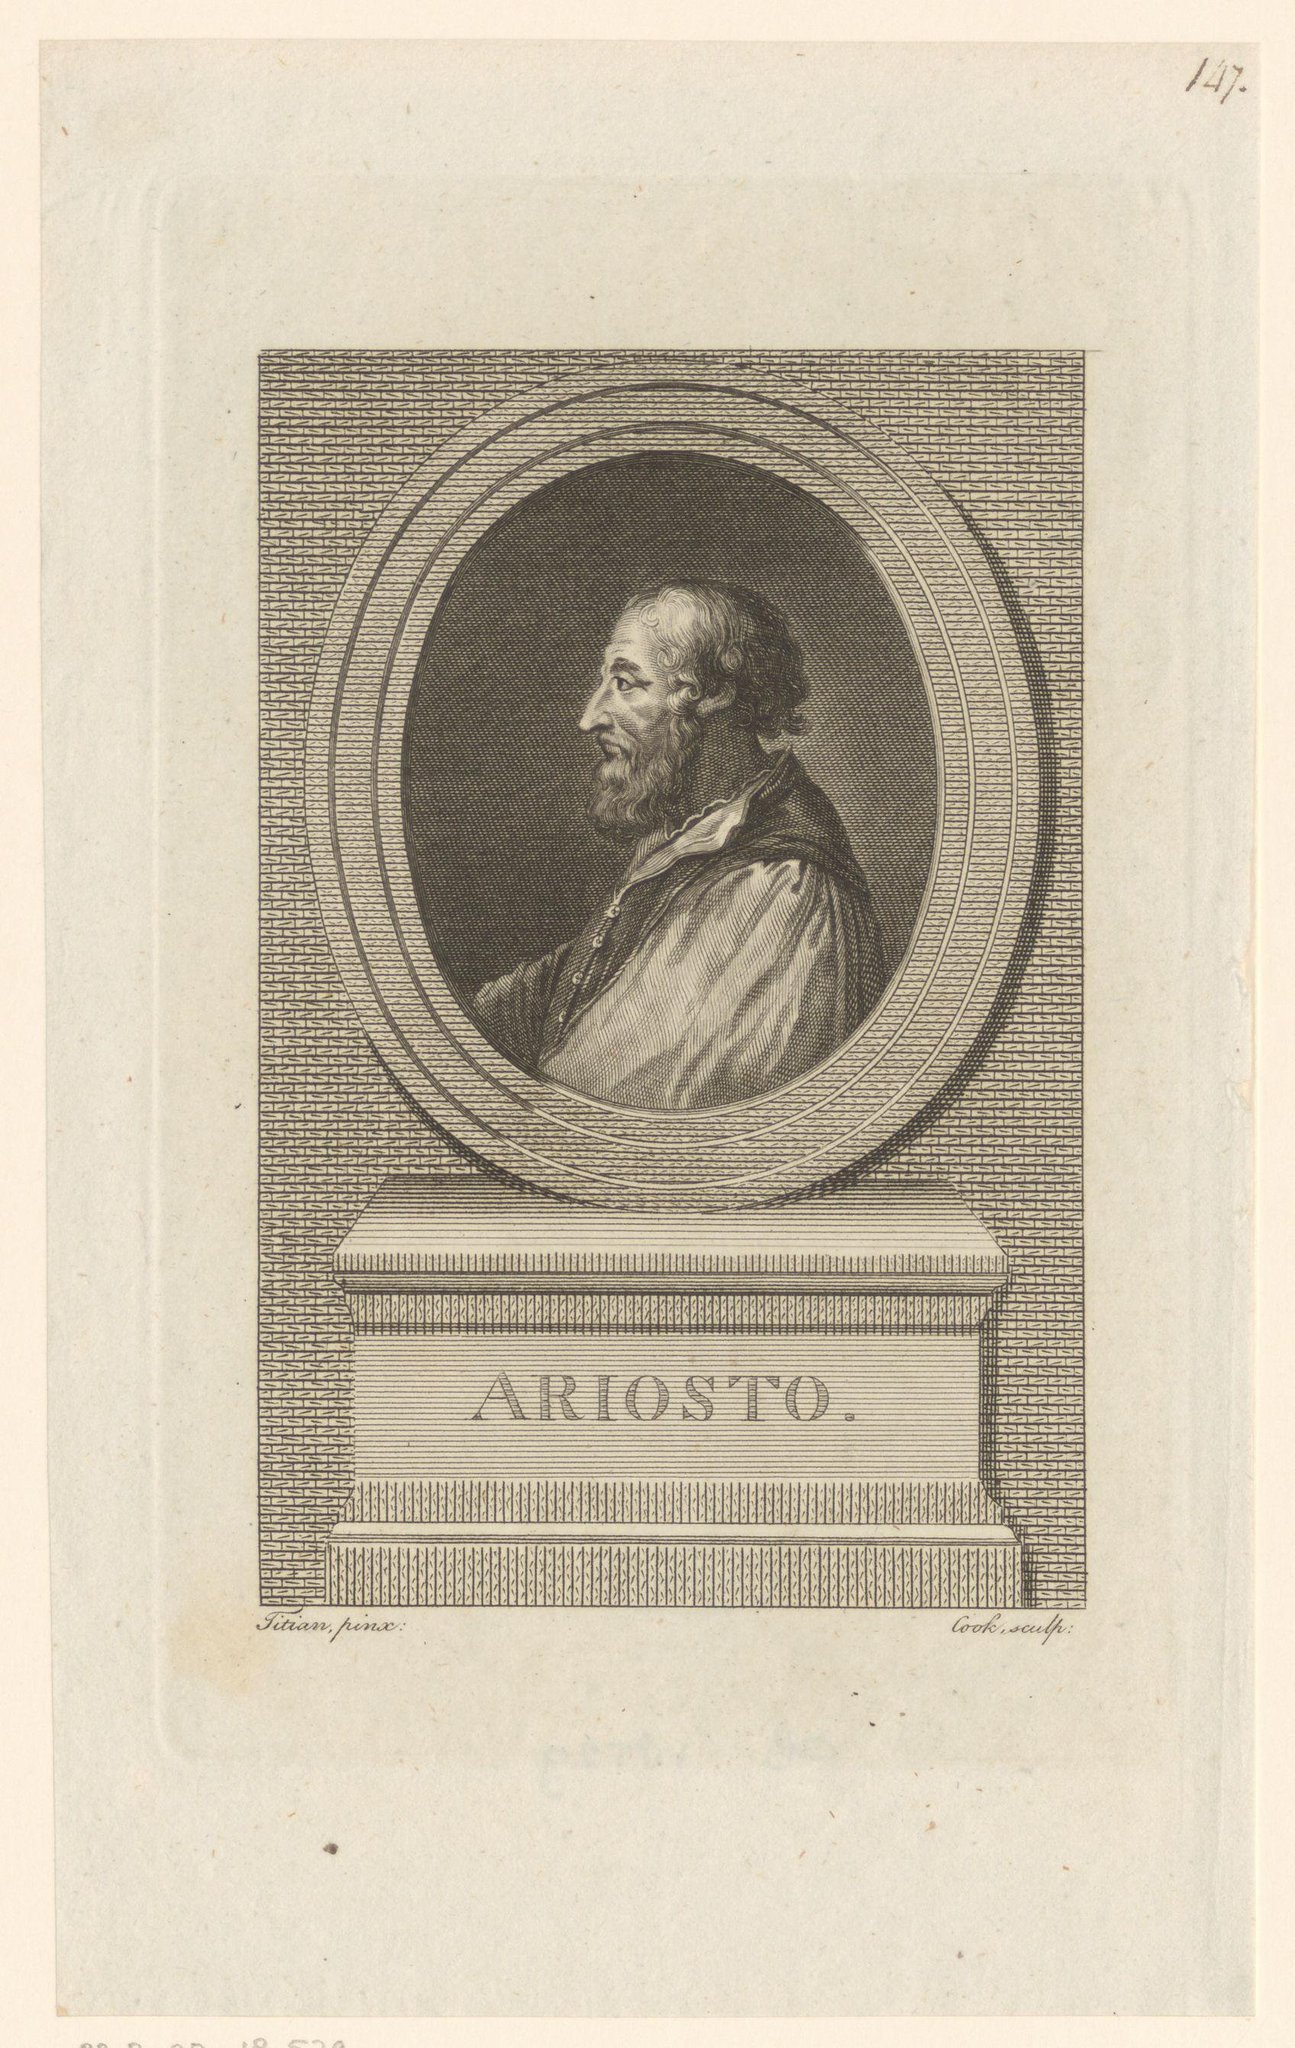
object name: print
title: Portret van Ariosto Ludovico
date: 1754-1818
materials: paper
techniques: engraving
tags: ludovico ariosto, historical persons, writer, poet, author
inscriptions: number: ‘147’, collector's mark: Lugt 2228